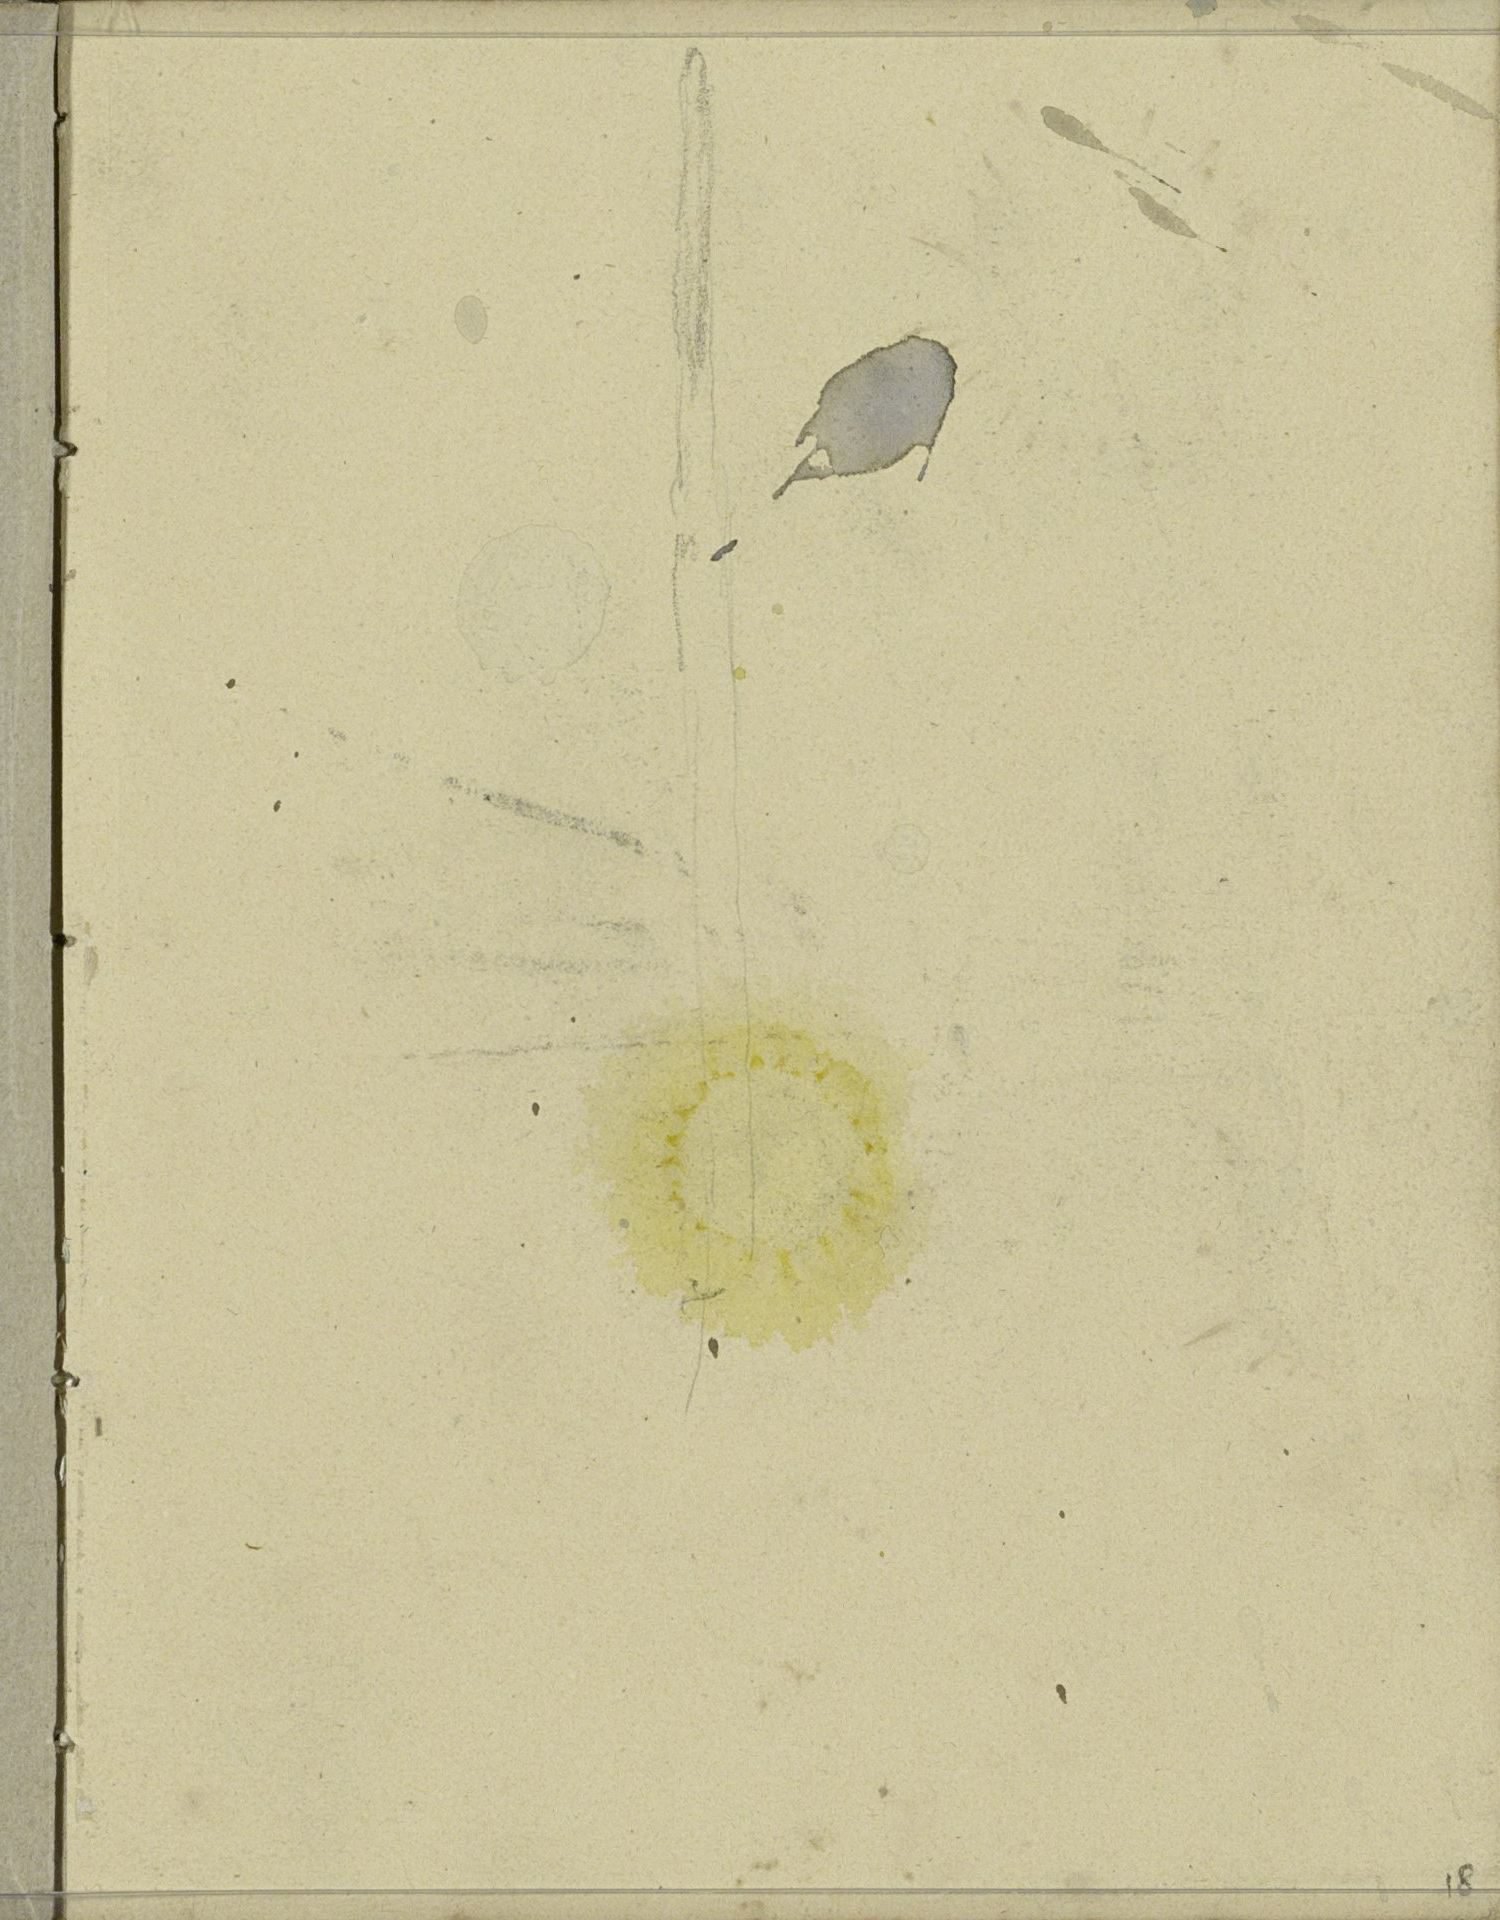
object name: sketchbook leaf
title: Studie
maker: johan hendrik weissenbruch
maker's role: draughtsman, painter, print maker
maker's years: 1824-1903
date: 1834-1903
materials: paper, pencil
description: Blad 18 recto uit een schetsboek met 34 bladen.